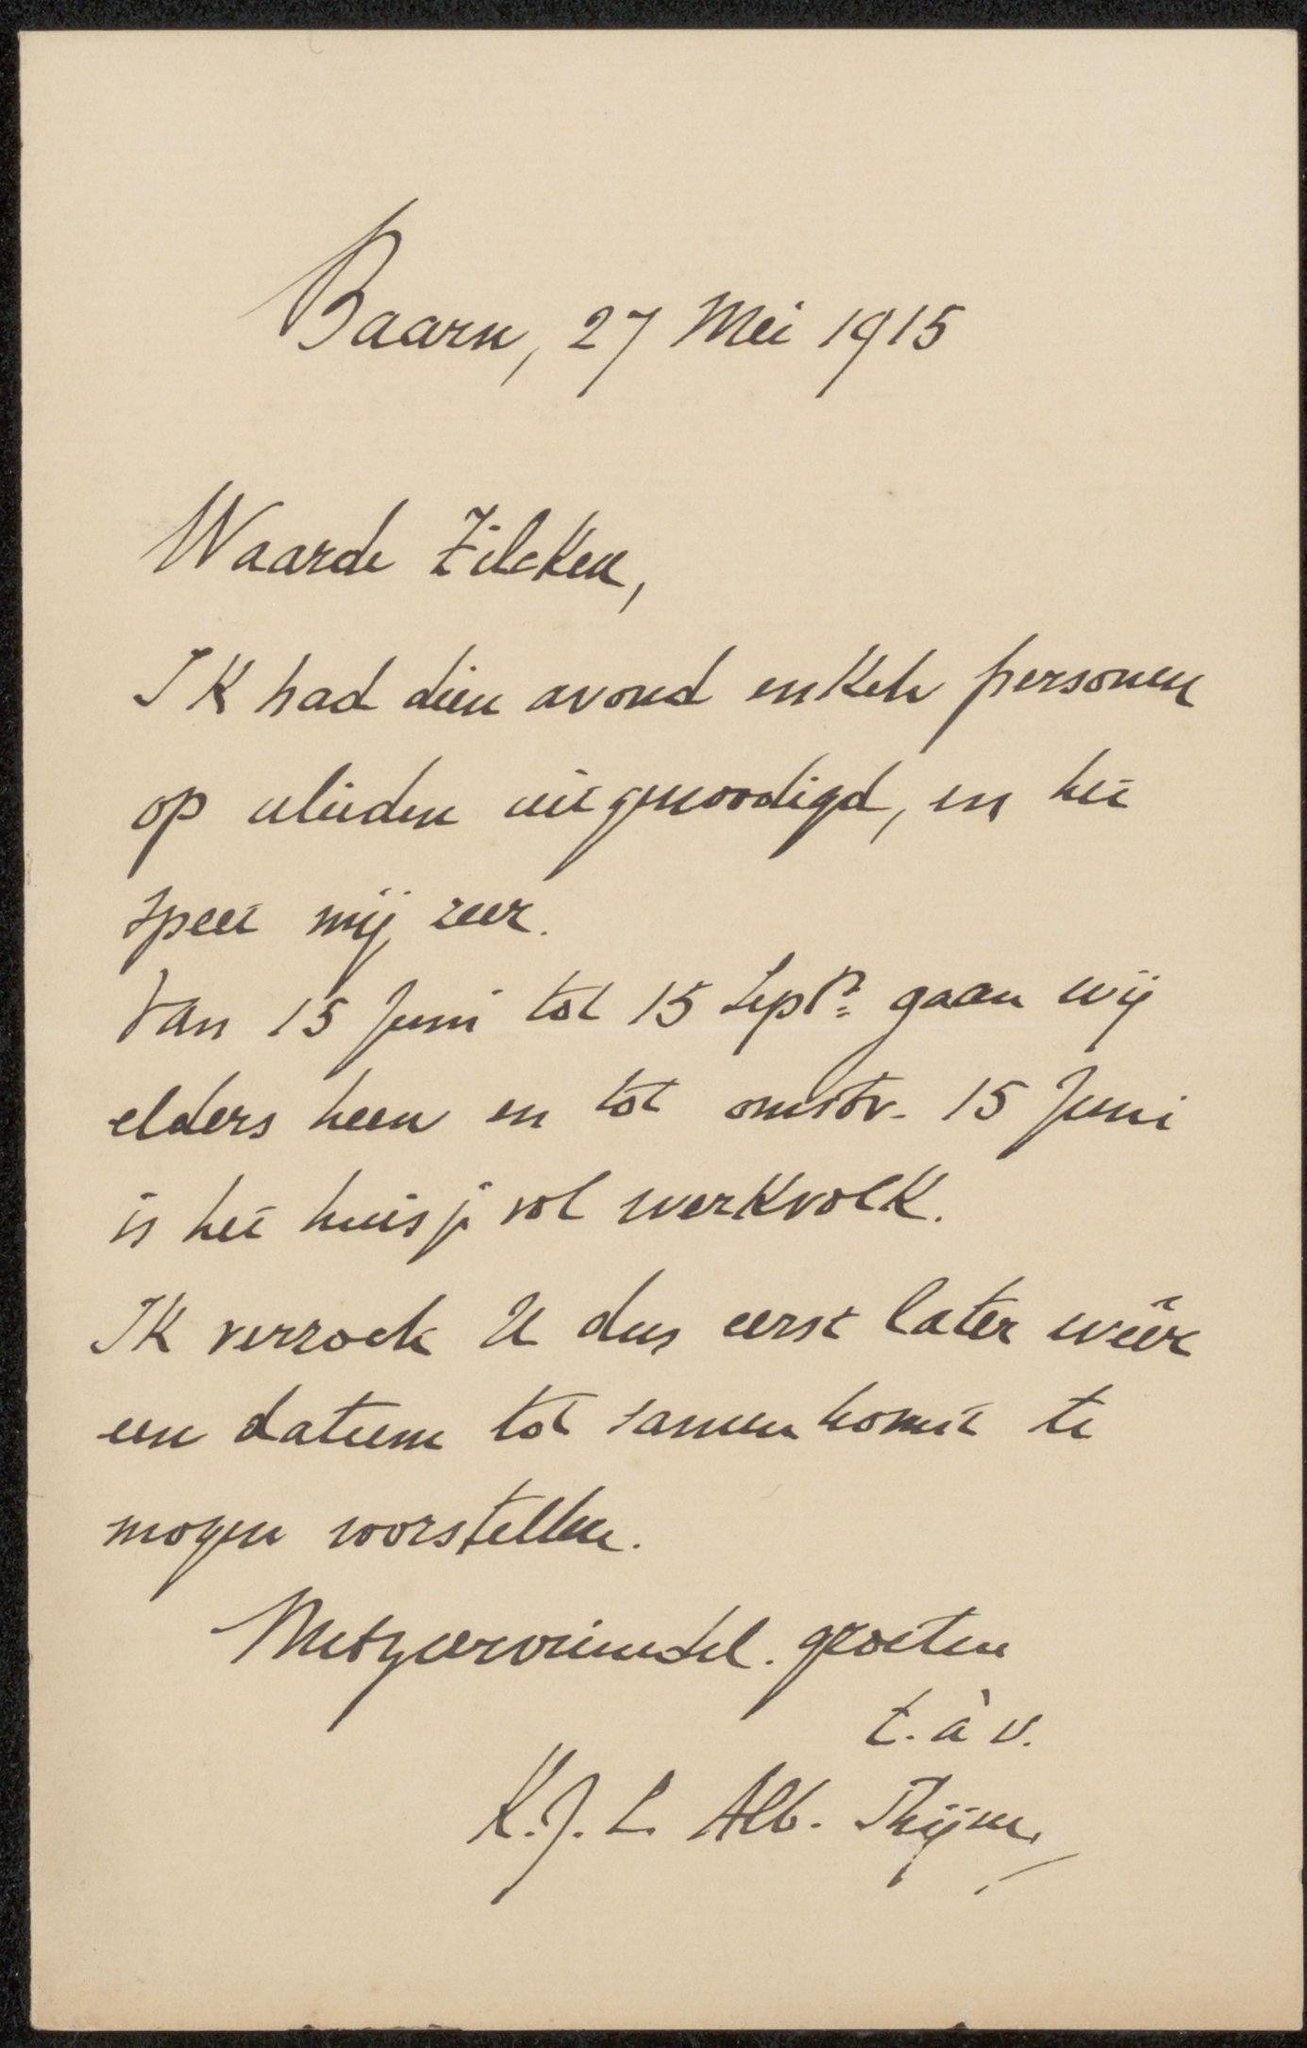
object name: letter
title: Brief aan Philip Zilcken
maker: karel johan lodewijk alberdingk thijm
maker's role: criticus, prozaschrijver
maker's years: 1864-1952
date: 1915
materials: ink, paper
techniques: pen, writing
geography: baarn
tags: painter, draughtsman, philip zilcken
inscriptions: collector's mark: ‘RPK’